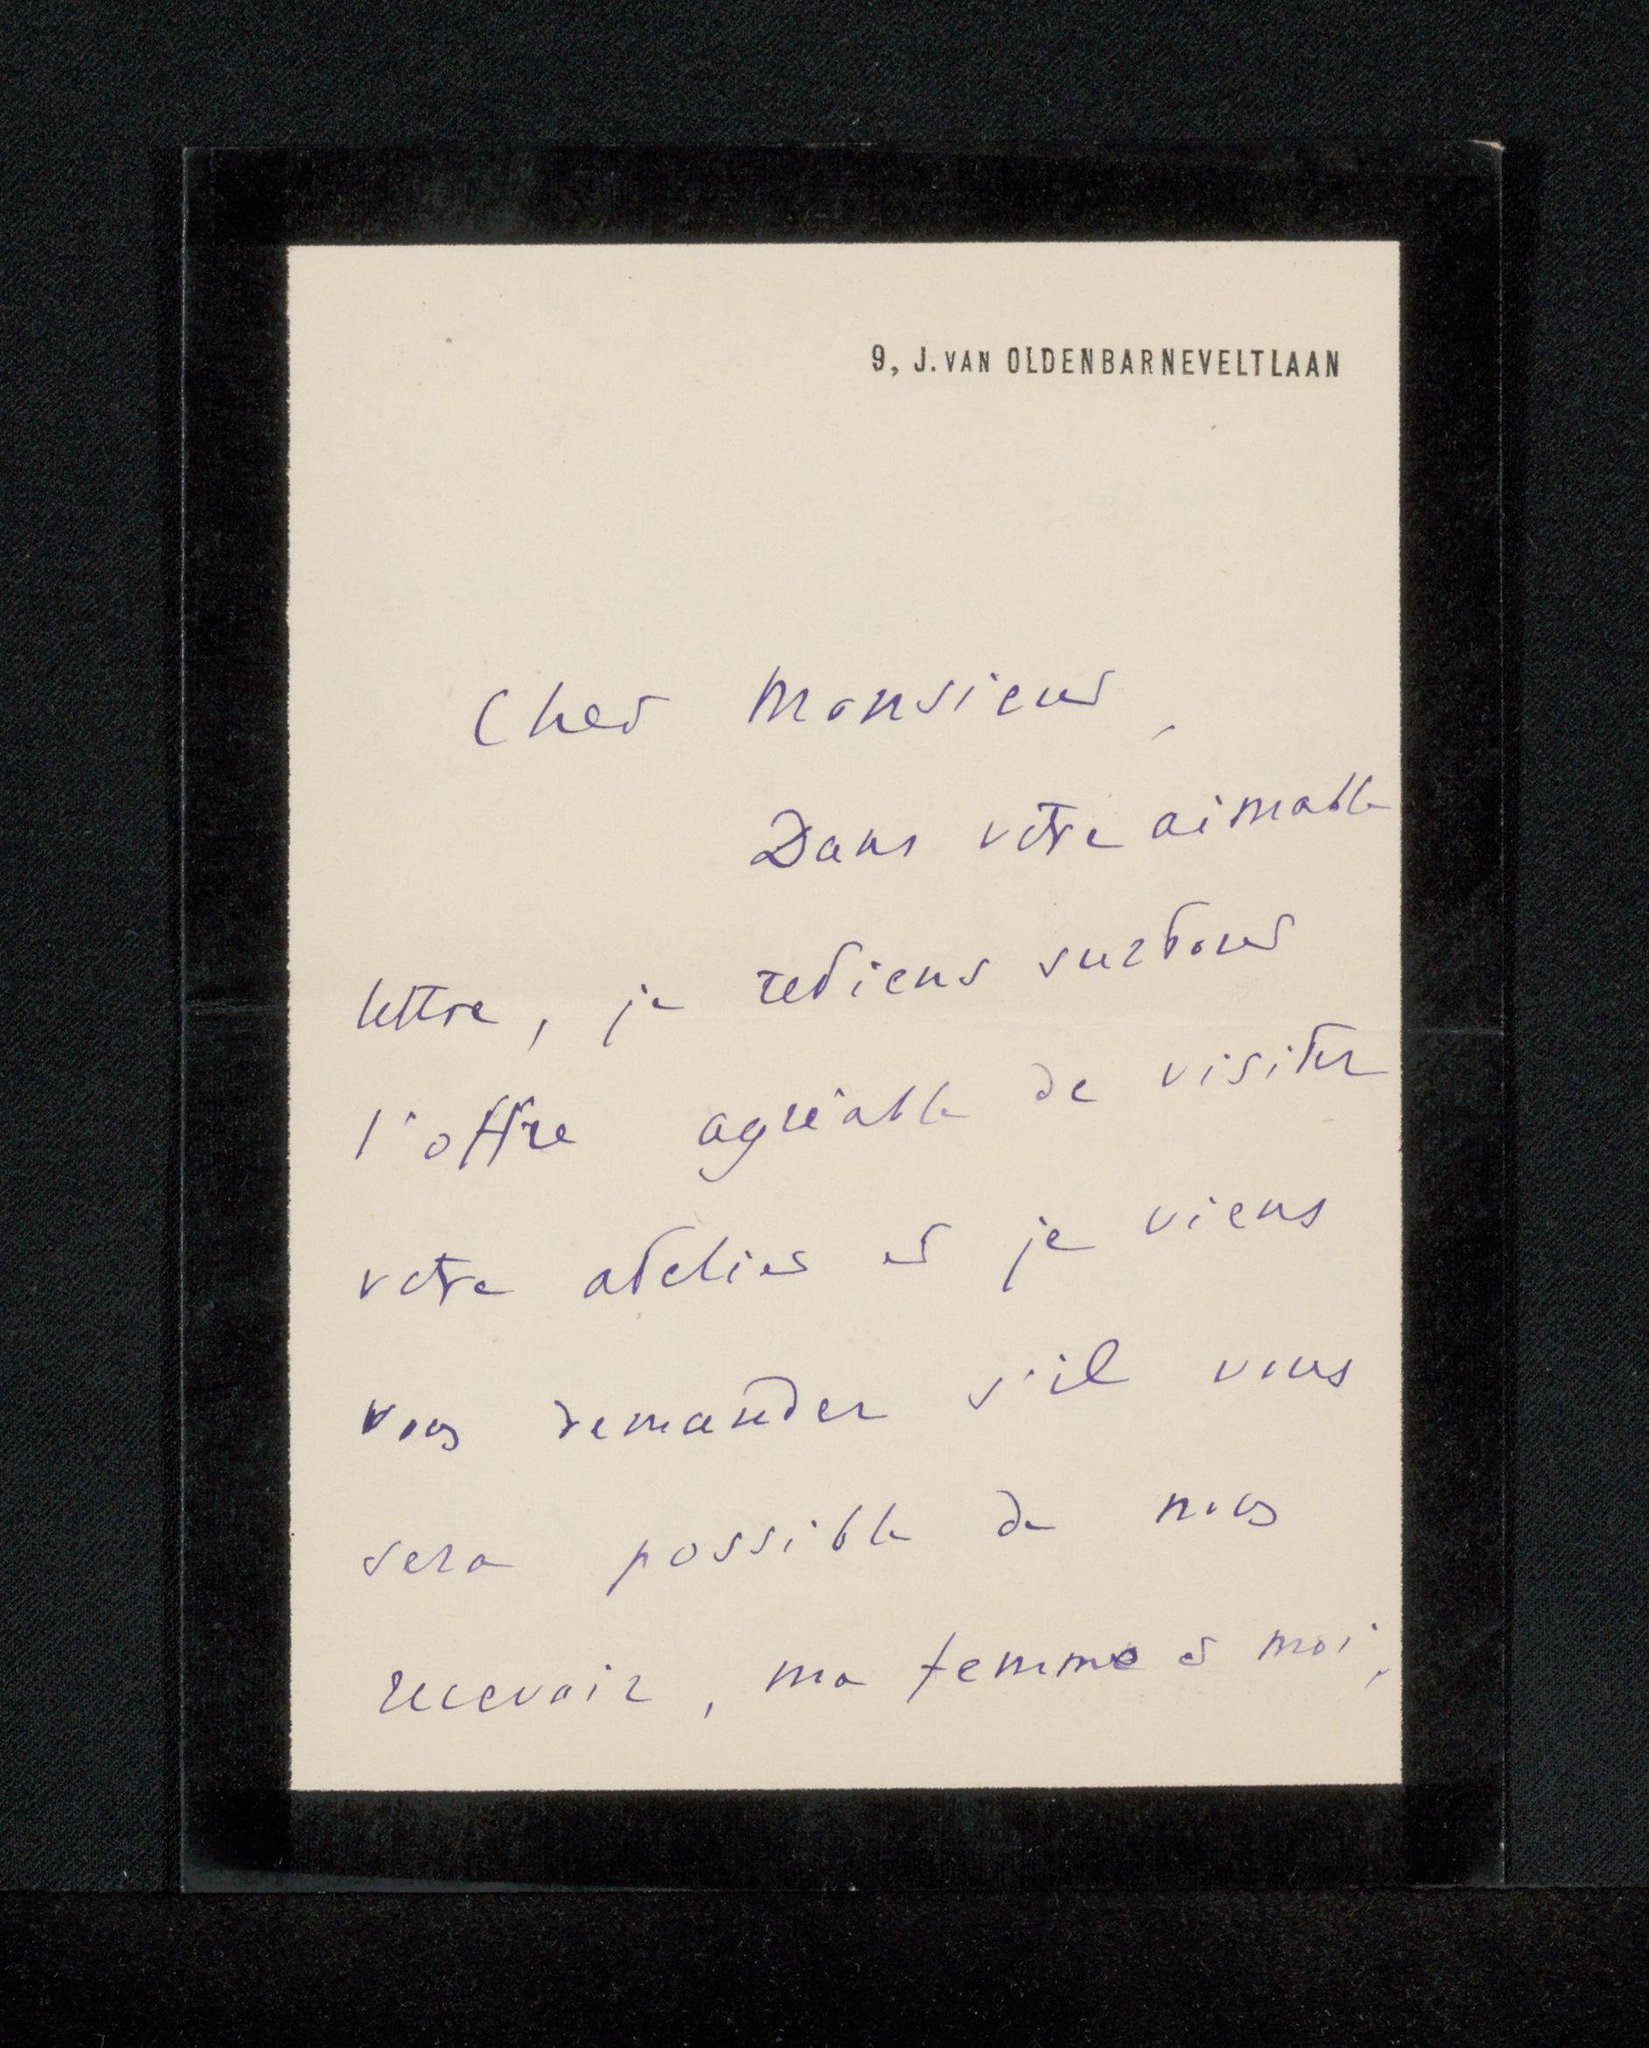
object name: letter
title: Brief aan Philip Zilcken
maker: joseph romieu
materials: ink, paper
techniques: pen, writing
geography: the hague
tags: the hague, painter, philip zilcken, workshop, studio of the artist (in general), exhibition ~ art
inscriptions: collector's mark: ‘RPK’, address: ‘9, J. VAN OLDENBARNEVELTLAAN’